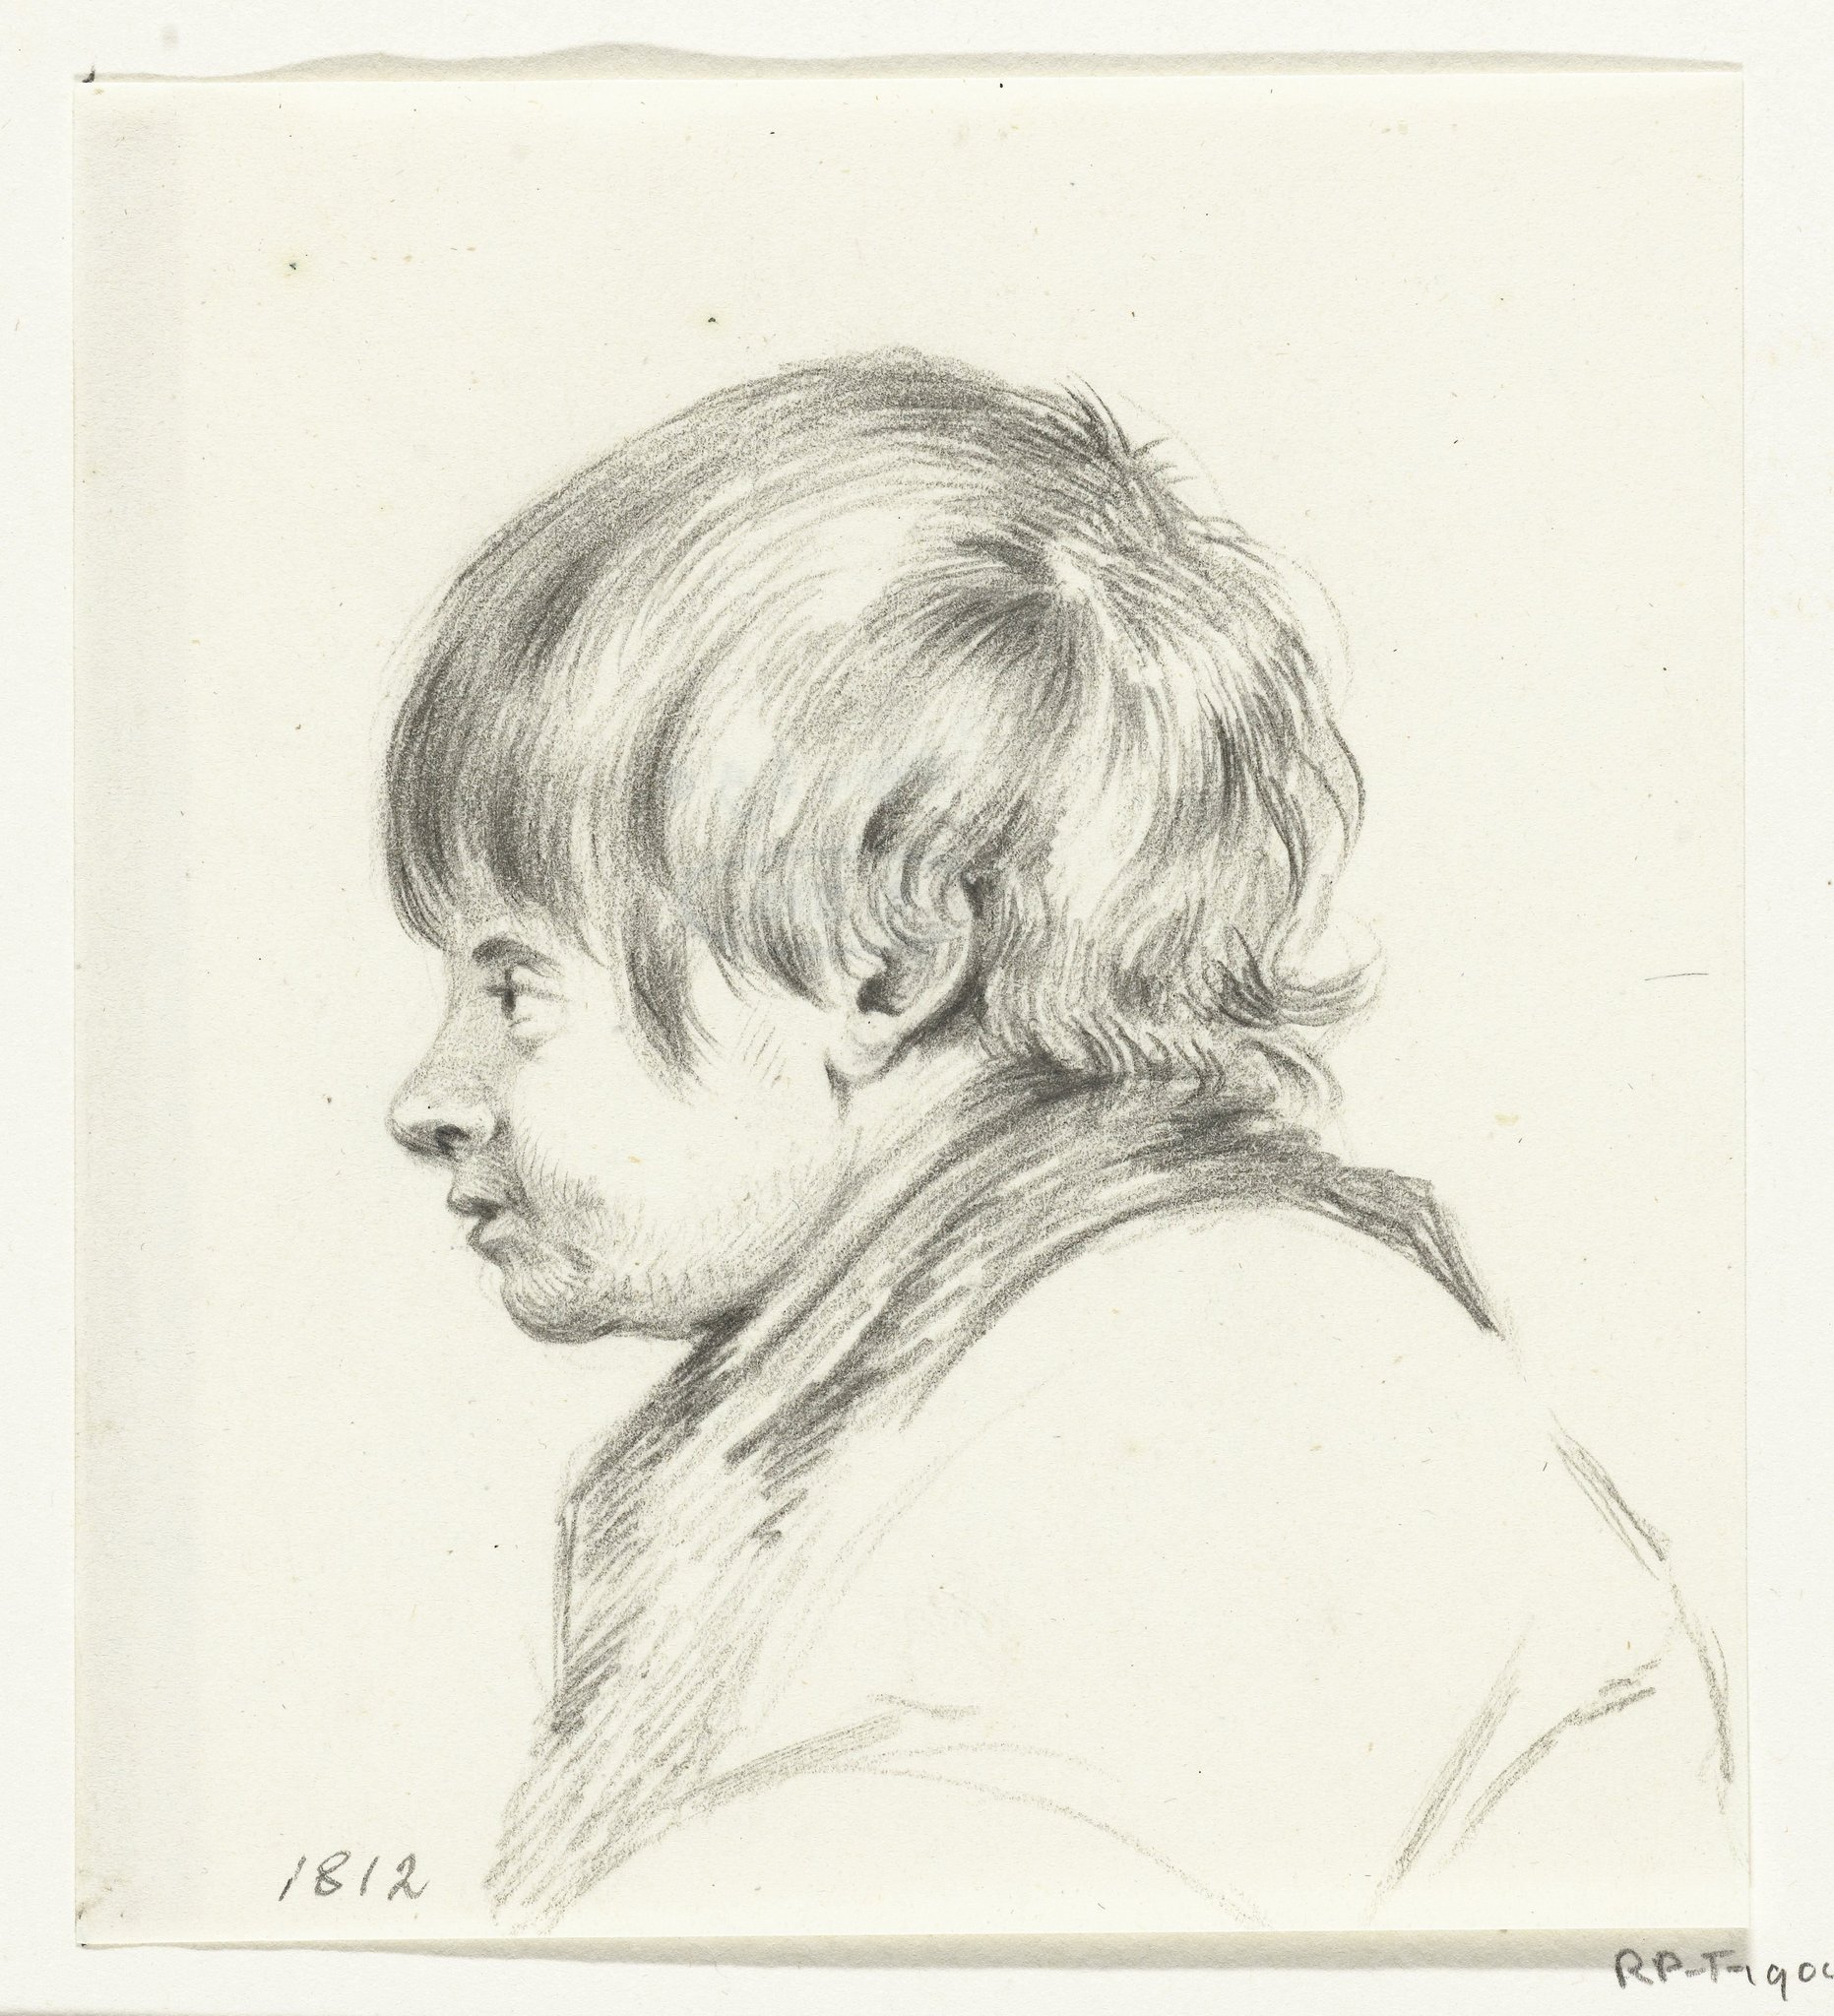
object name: drawing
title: Buste van een jongen, naar links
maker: jean bernard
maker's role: draughtsman, print maker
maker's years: 1765-1833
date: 1812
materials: chalk, paper, pencil